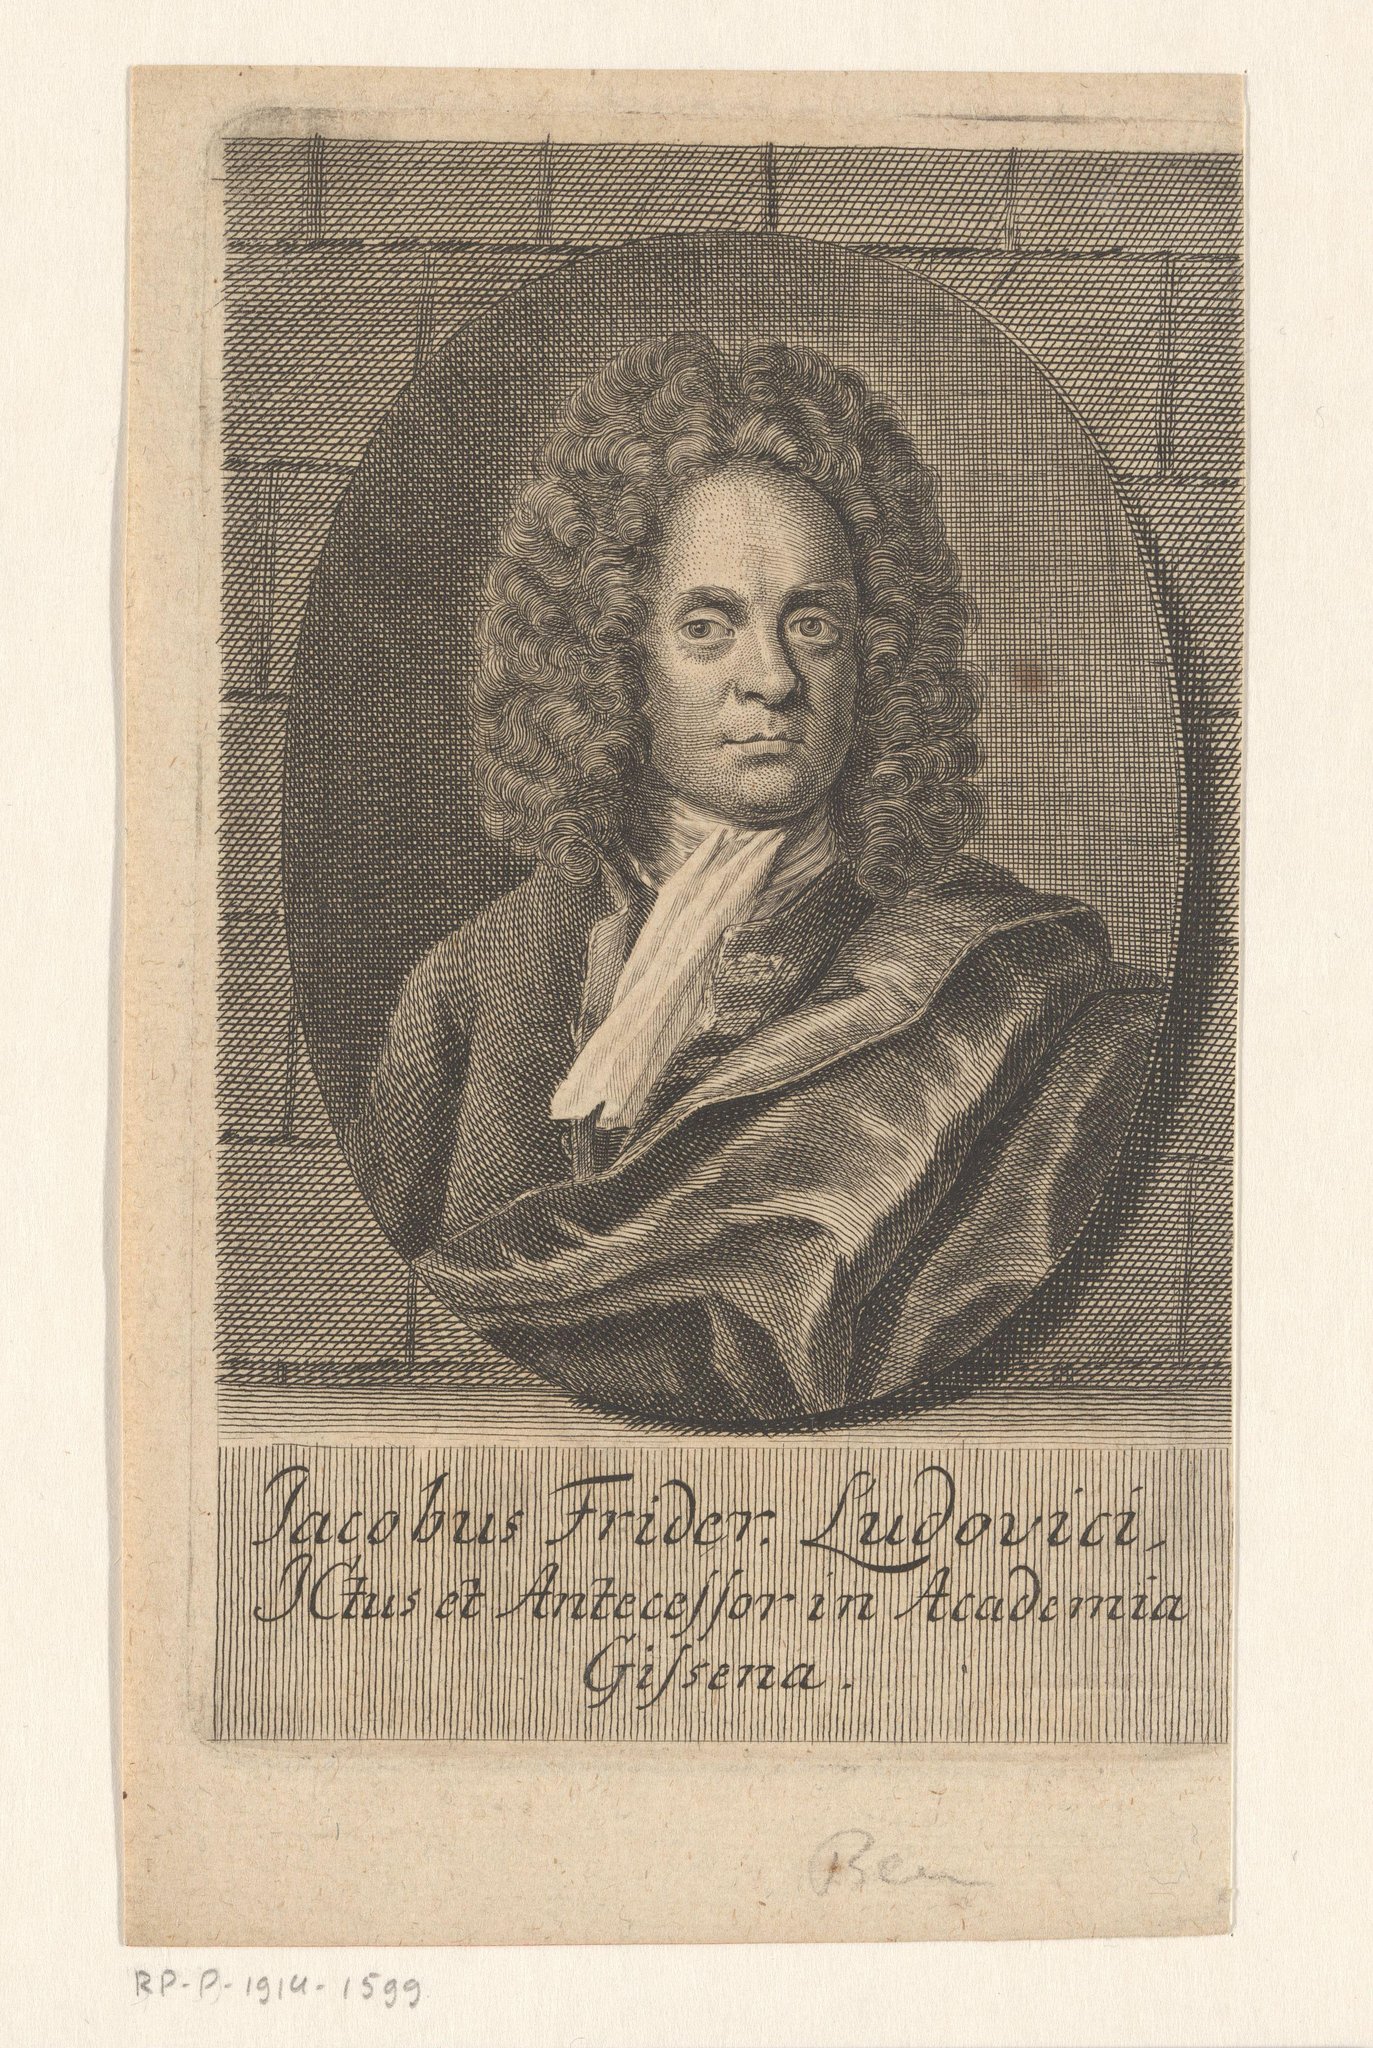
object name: print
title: Portret van Jacob Friedrich Ludovici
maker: martin bernigeroth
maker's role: print maker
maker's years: 1670-1733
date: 1722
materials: paper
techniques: engraving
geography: leipzig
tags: historical persons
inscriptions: collector's mark: Lugt 2228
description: Prent ook gebruikt in: Deutsche Acta Eruditorum (...). dl. 83. Leipzig: Johann Gottlieb Gleditsch, 1722